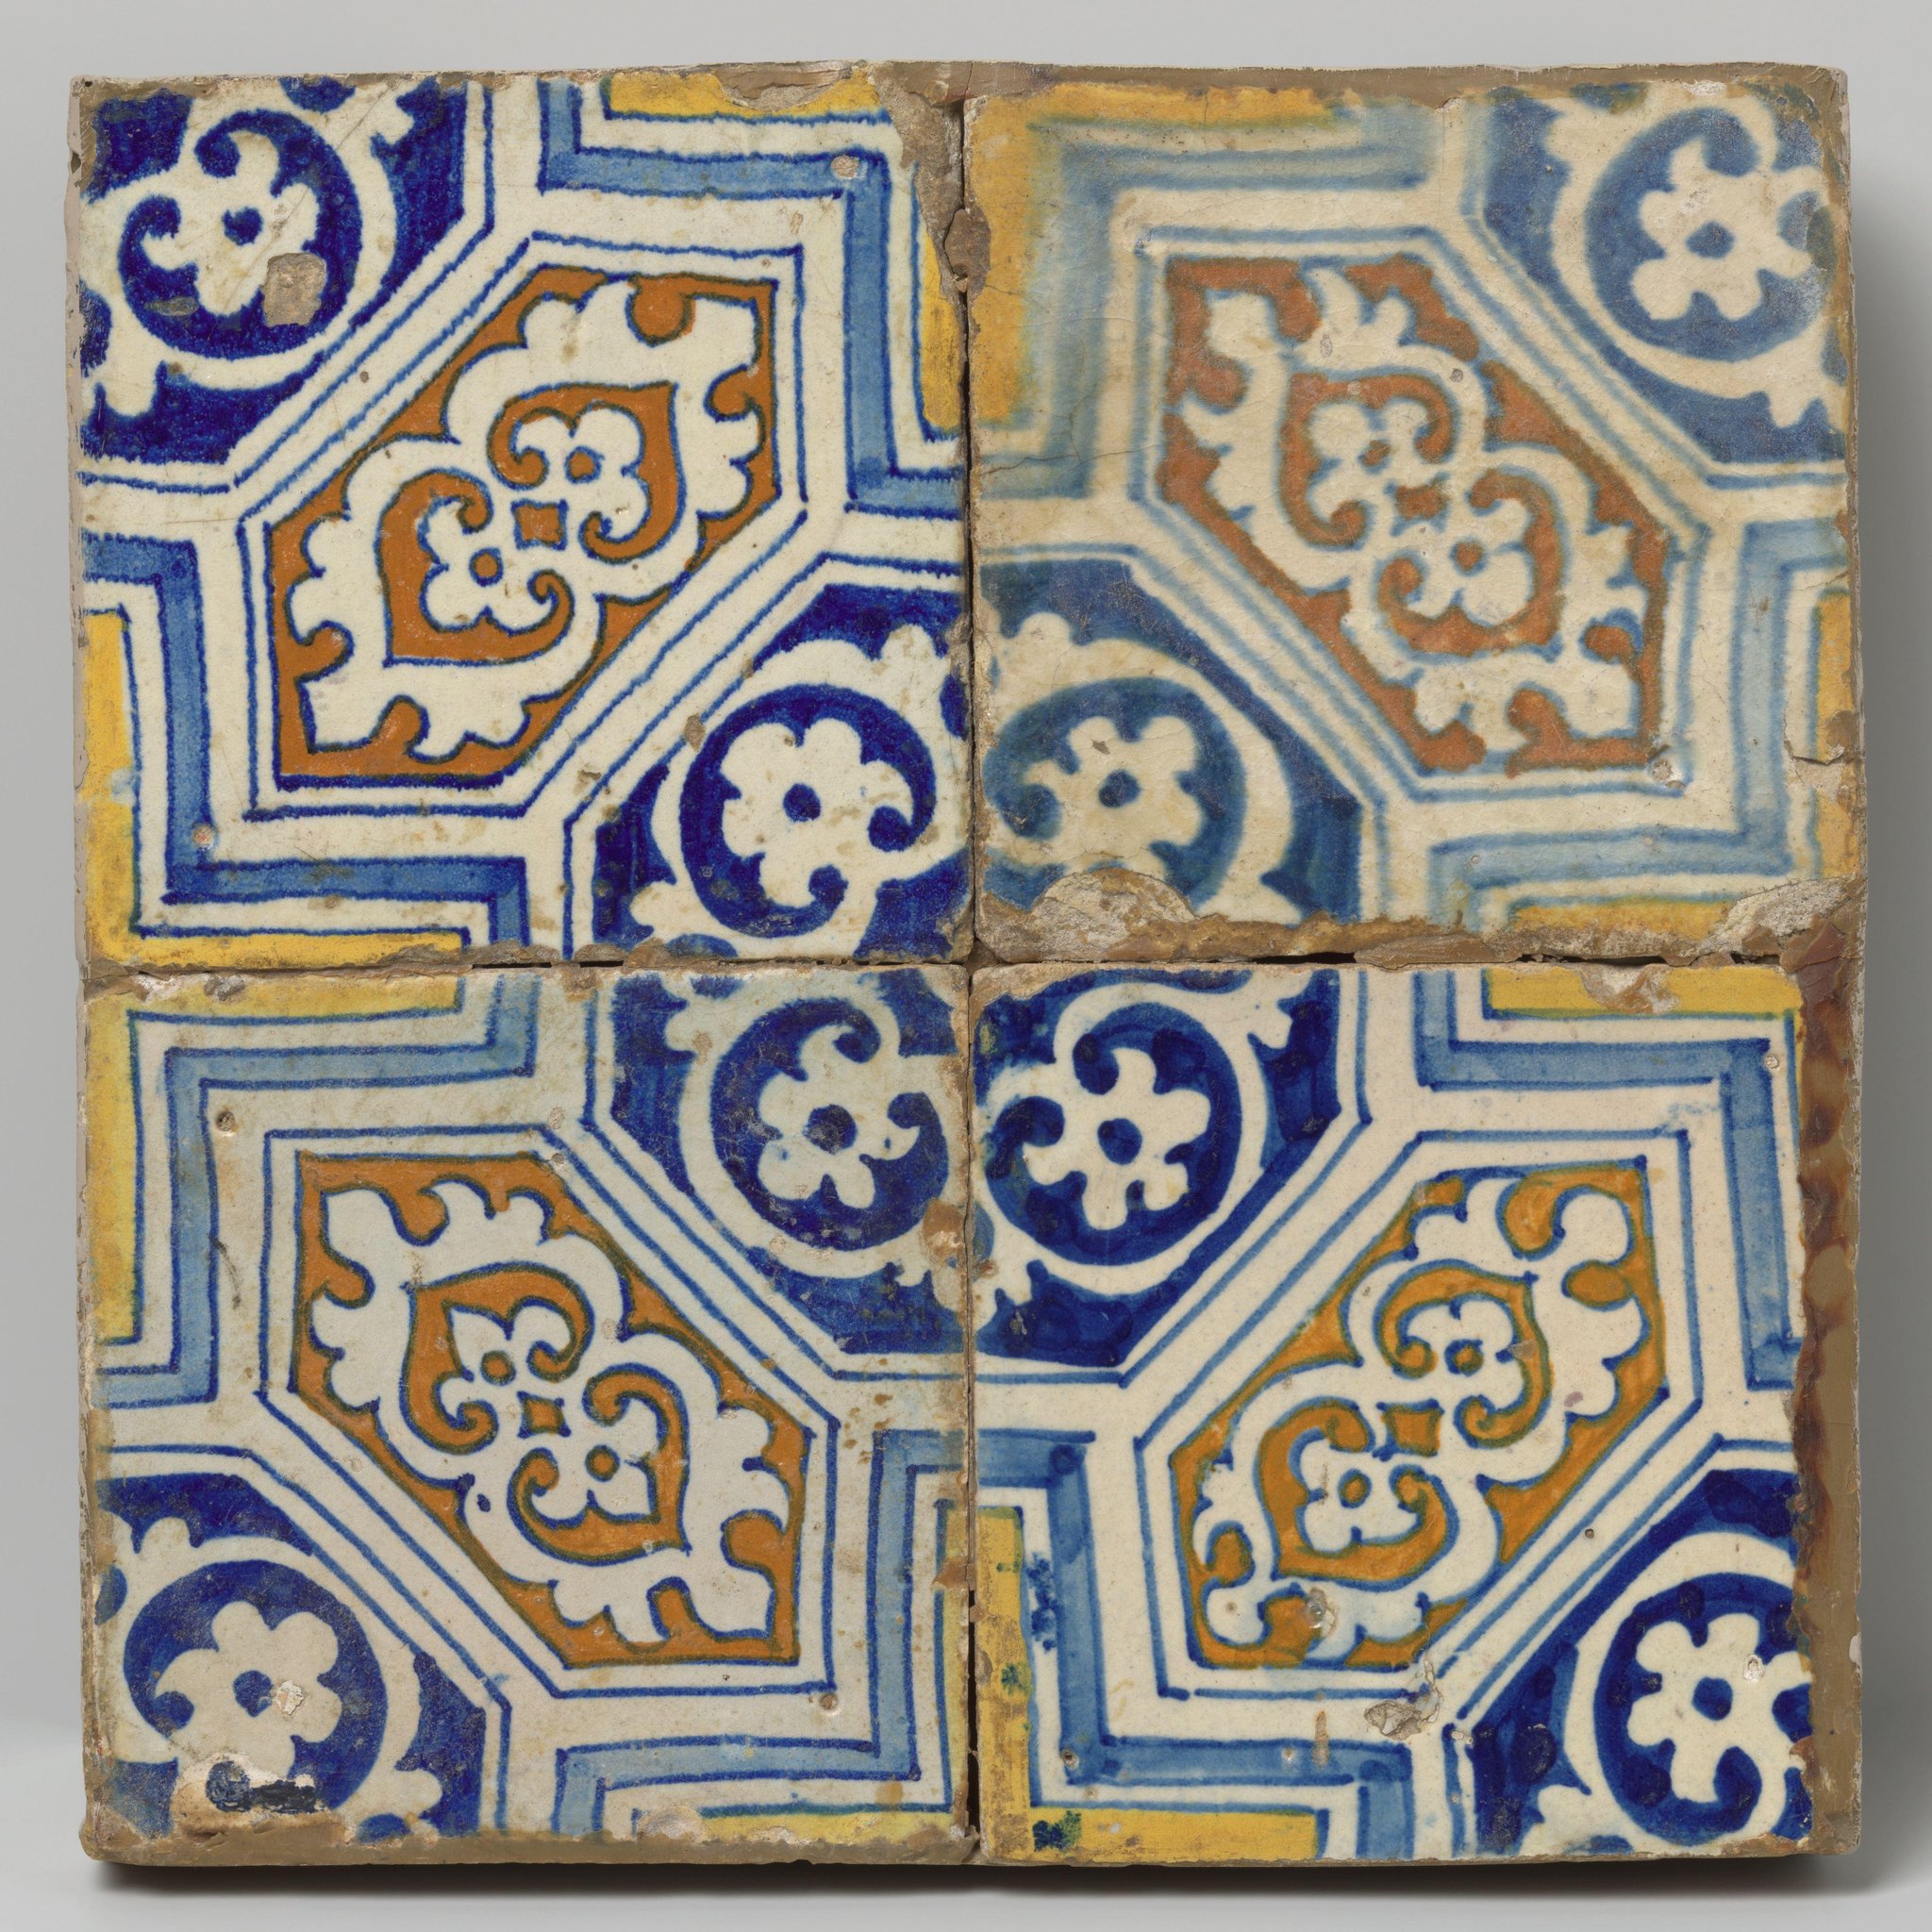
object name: tegelveld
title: Veld van vier tegels met patroon van bladeren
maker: Anonymous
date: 1560-1600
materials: earthenware, glaze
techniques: maiolica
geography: netherlands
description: Veld van vier tegels (2 x 2) elk met veelkleurig (blauw, geel en oranjebruin) geschilderde bladpatronen binnen geometrische omlijning.